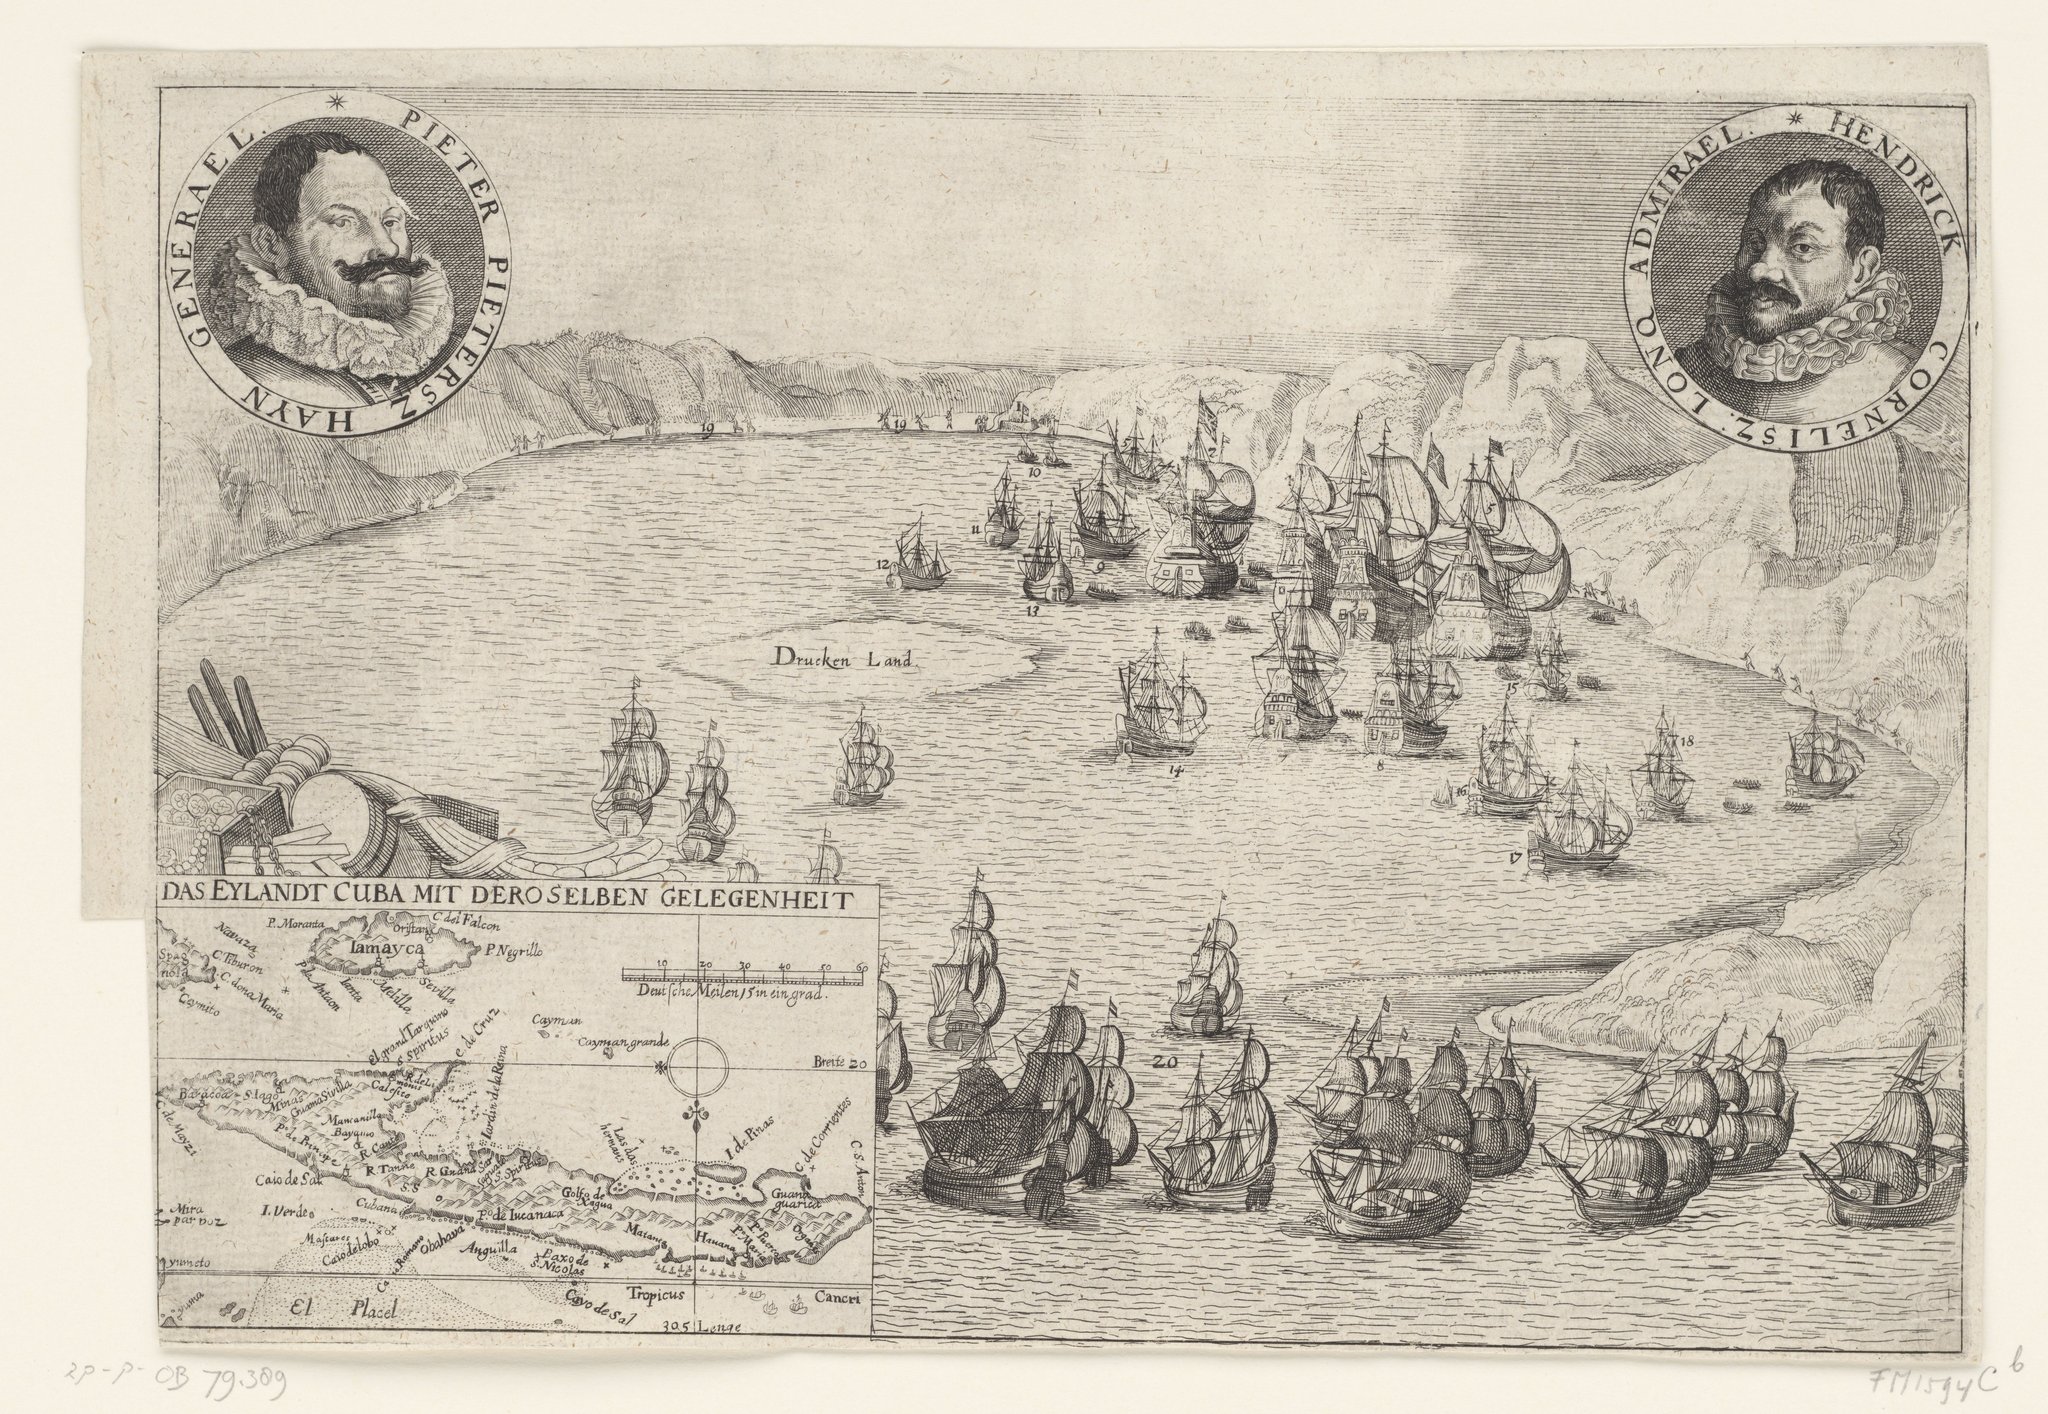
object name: print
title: Verovering van de Zilvervloot in de Baai van Matanzas door admiraal Piet Hein, 1628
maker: Anonymous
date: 1628-1649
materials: paper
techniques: etching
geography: germany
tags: delfshaven, ships (in general) (+ propulsion of vehicle, ship, etc. by wind), capture of the spanish treasure fleet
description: Verovering van de Zilvervloot in de Baai van Matanzas door een vloot van de WIC onder bevel van admiraal Piet Hein, 8 september 1628. Linksonder een kaart van het eiland Cuba. Bovenaan ronde portretten van de admiralen Hendrick Cornelisz. Loncq en Piet Hein.